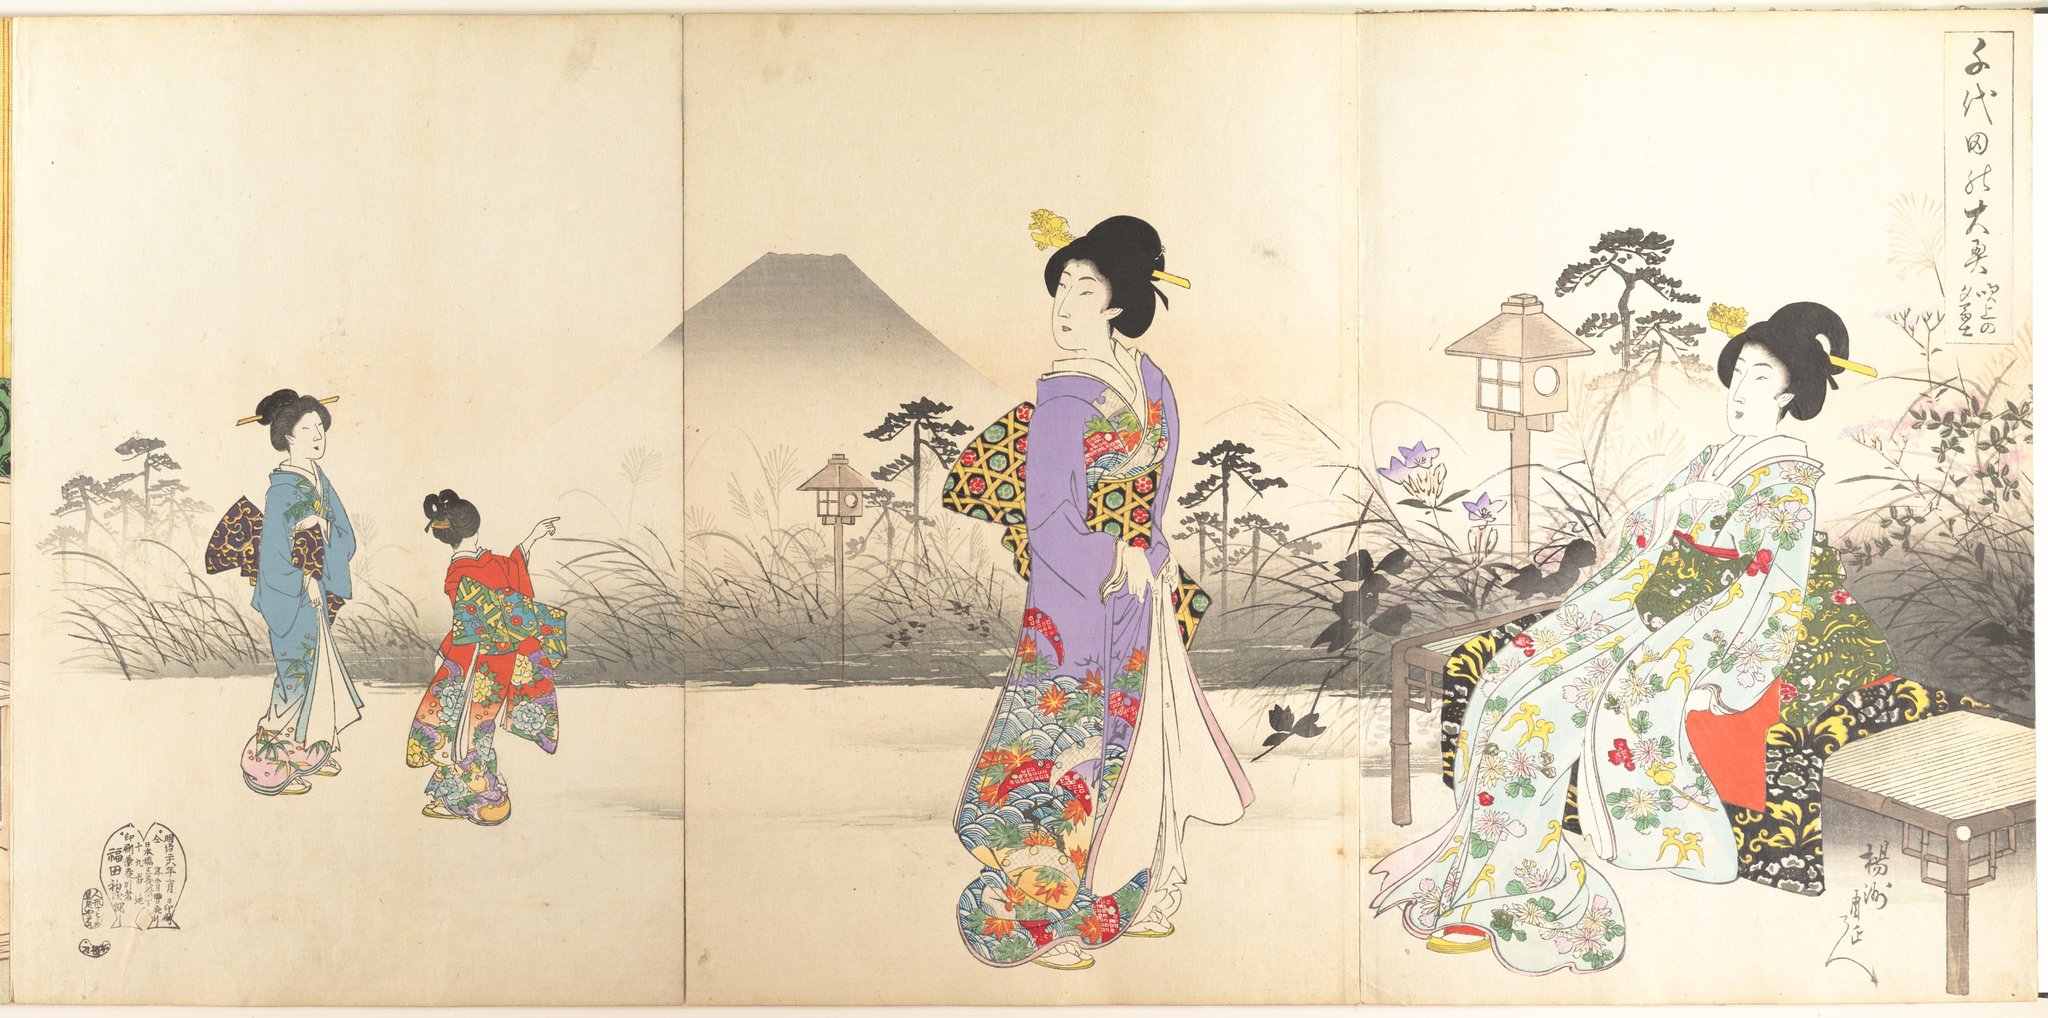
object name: print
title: Chiyoda Castle (Album of Women)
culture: japanese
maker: yōshū (hashimoto) chikanobu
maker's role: artist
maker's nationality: japanese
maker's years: 1838-1912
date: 1895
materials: ink, paper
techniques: woodblock print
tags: women,mountains,benches